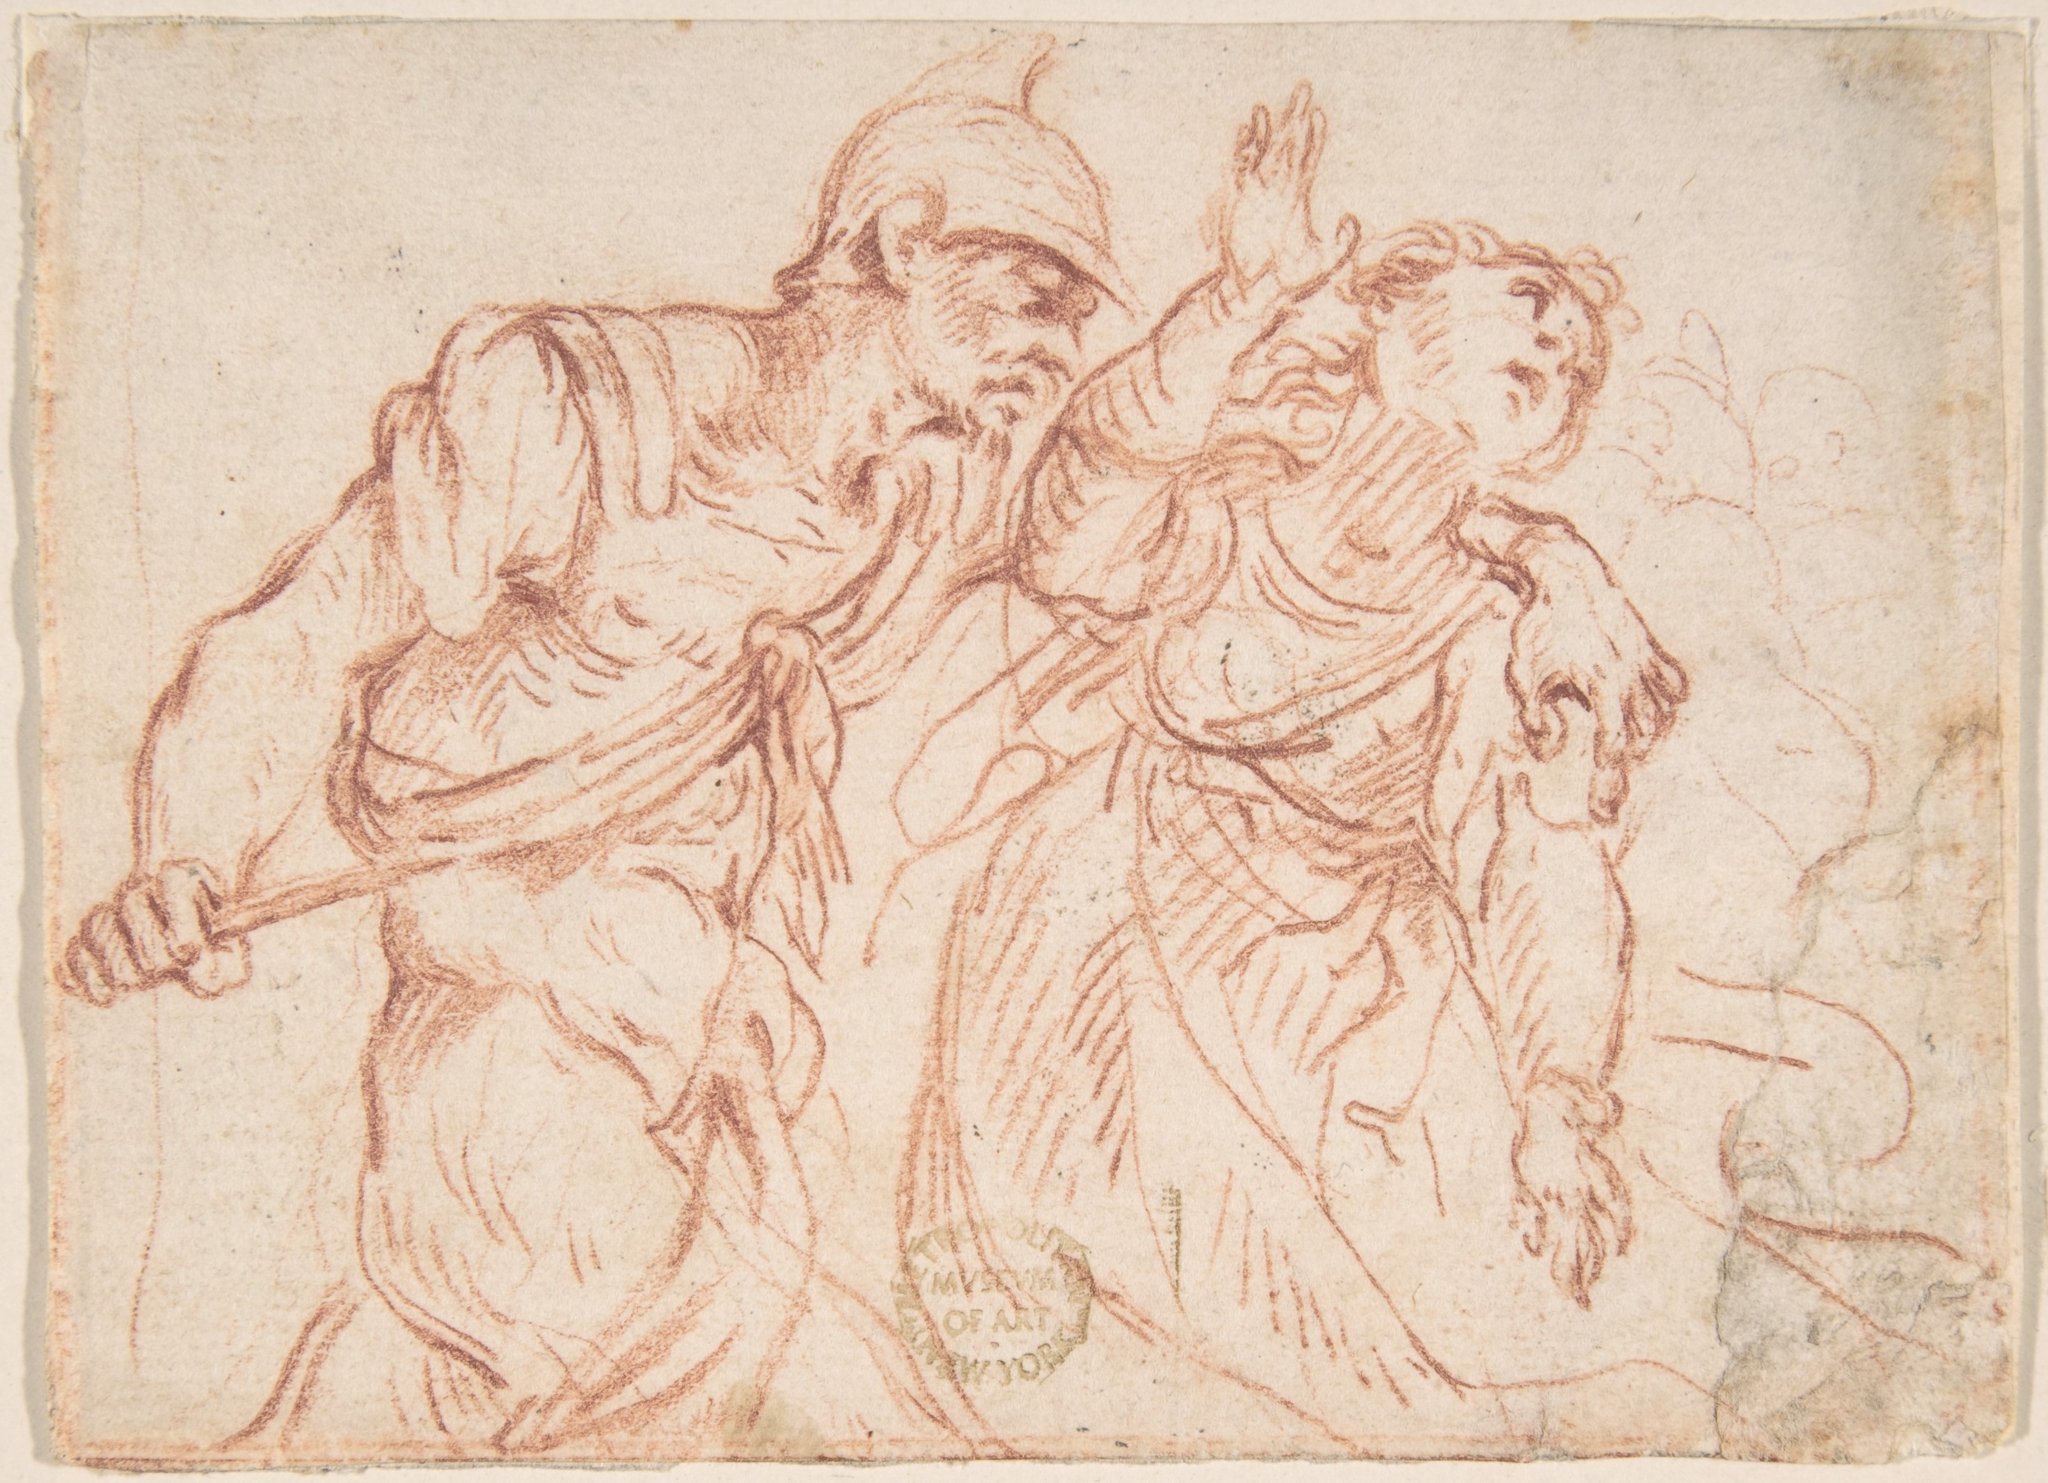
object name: drawing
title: Soldier Stabbing a Woman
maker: anonymous, italian, roman-bolognese, 17th century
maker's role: artist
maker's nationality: italian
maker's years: 1600-1700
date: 1601-1700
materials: chalk, paper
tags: soldiers,suffering,men,women